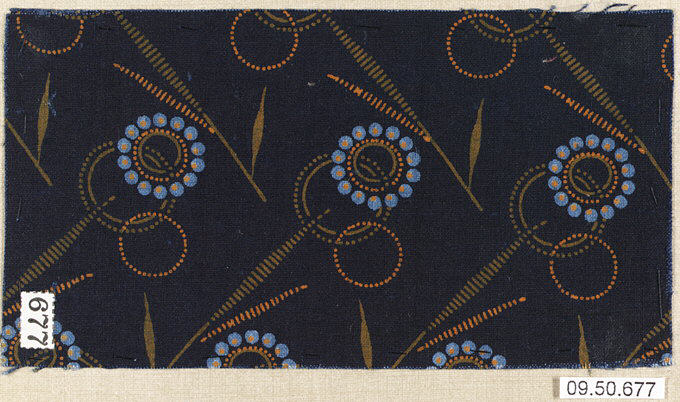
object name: piece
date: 1801-1900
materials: cotton